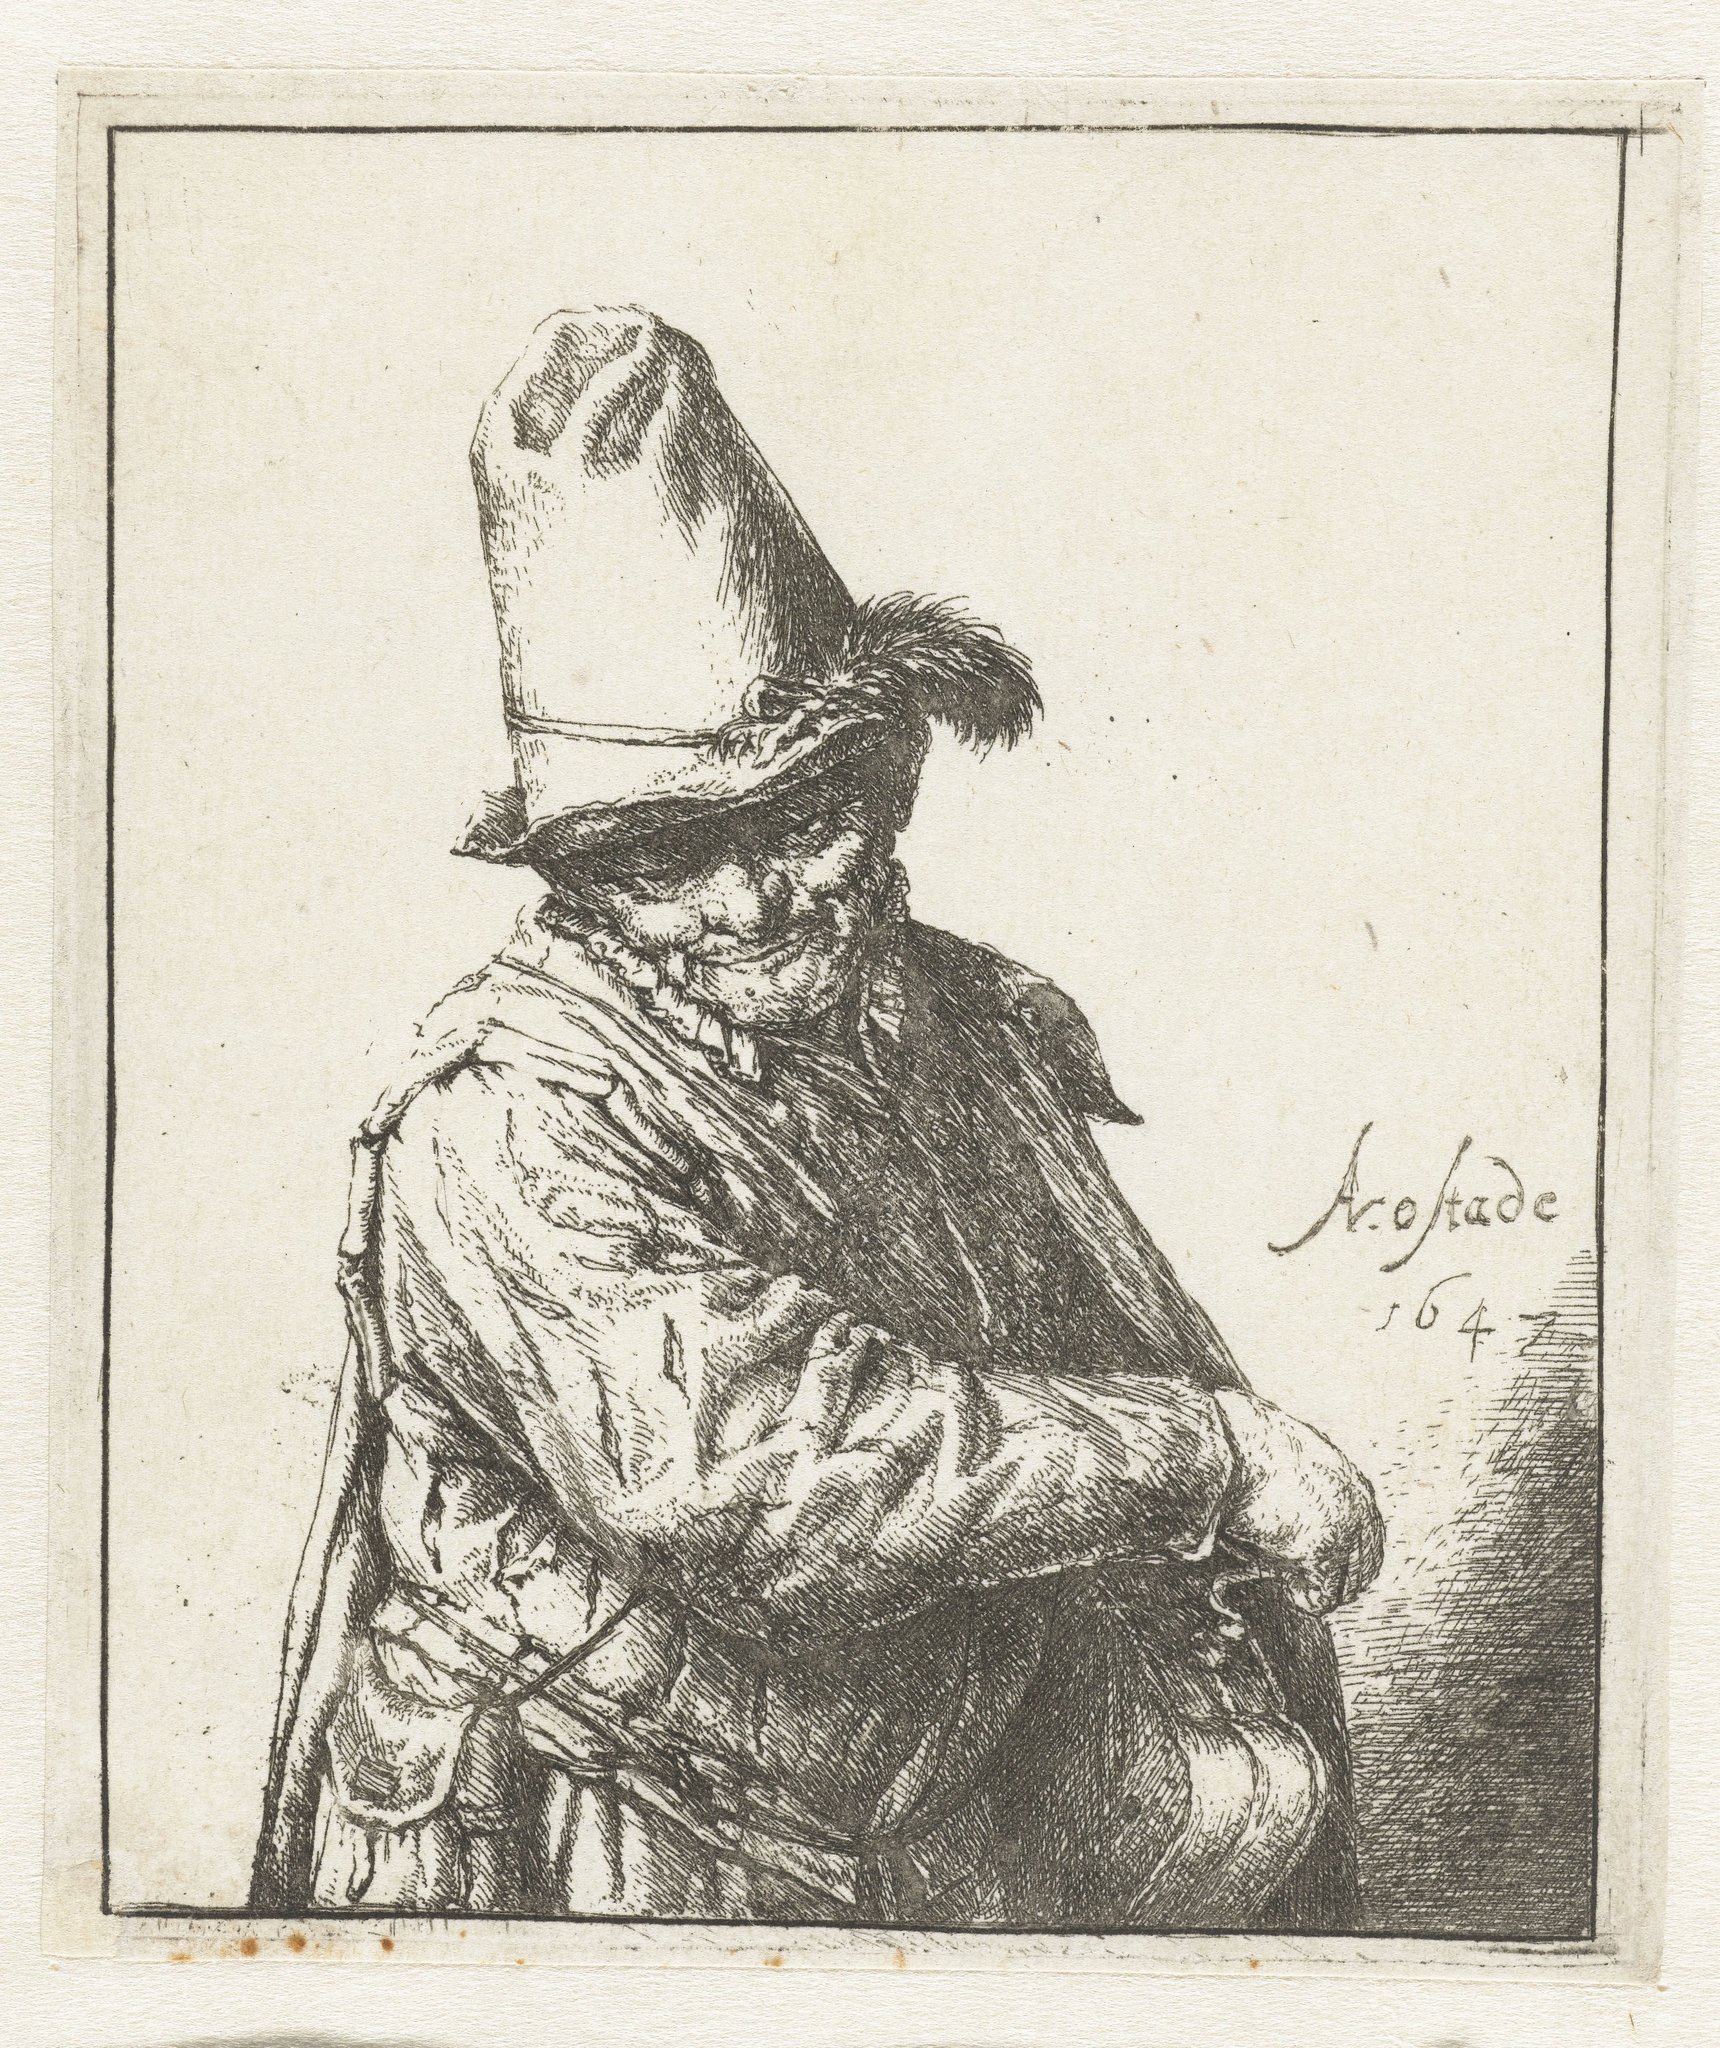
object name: print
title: Lierdraaier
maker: adriaen van ostade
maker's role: draughtsman, painter, print maker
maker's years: 1610-1685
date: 1647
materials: paper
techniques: etching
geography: haarlem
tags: hurdy-gurdy, hurdy-gurdy player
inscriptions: collector's mark: Lugt 240